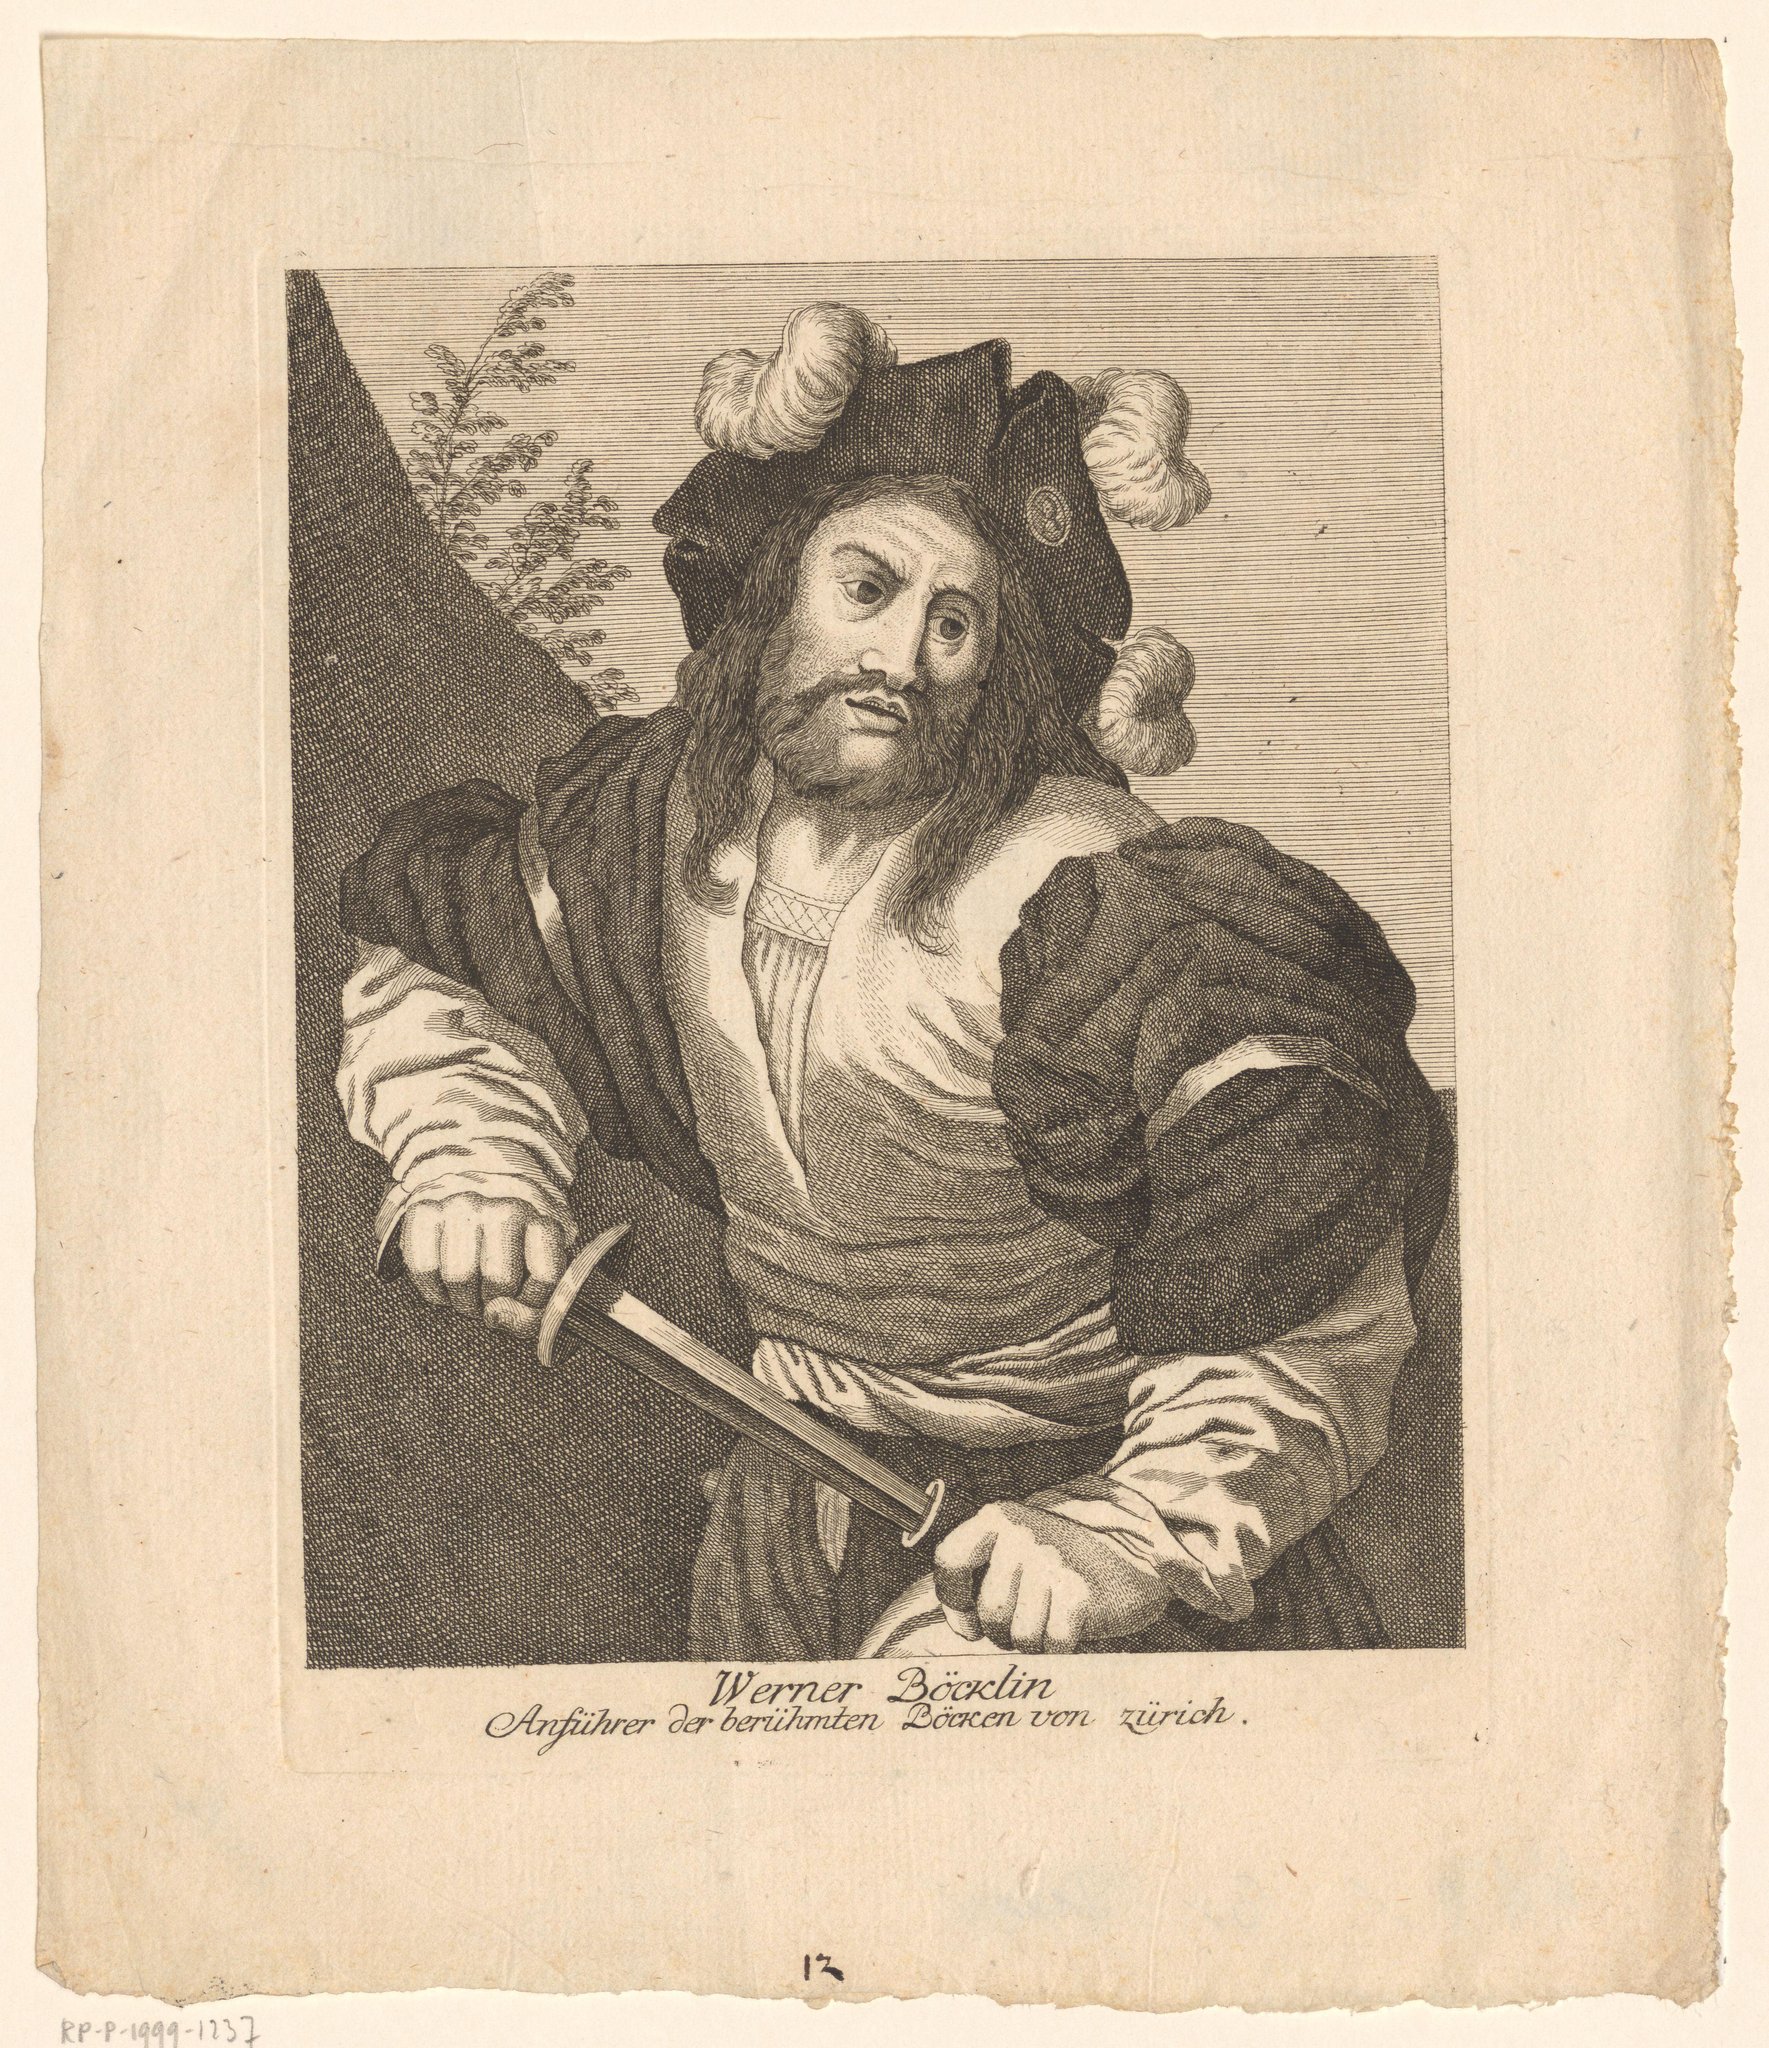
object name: print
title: Portret van Werner Böcklin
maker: Anonymous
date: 1750-1799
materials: paper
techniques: engraving, etching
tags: historical persons, hacking and thrusting weapons: sword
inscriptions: collector's mark: Lugt 2760, collector's mark: Lugt 2228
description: Prent mogelijk uit: Merckwürdiger Überbleibseln von Alterthümeren der Schweitz (...). Zürich: Johannes Müller, 1776.